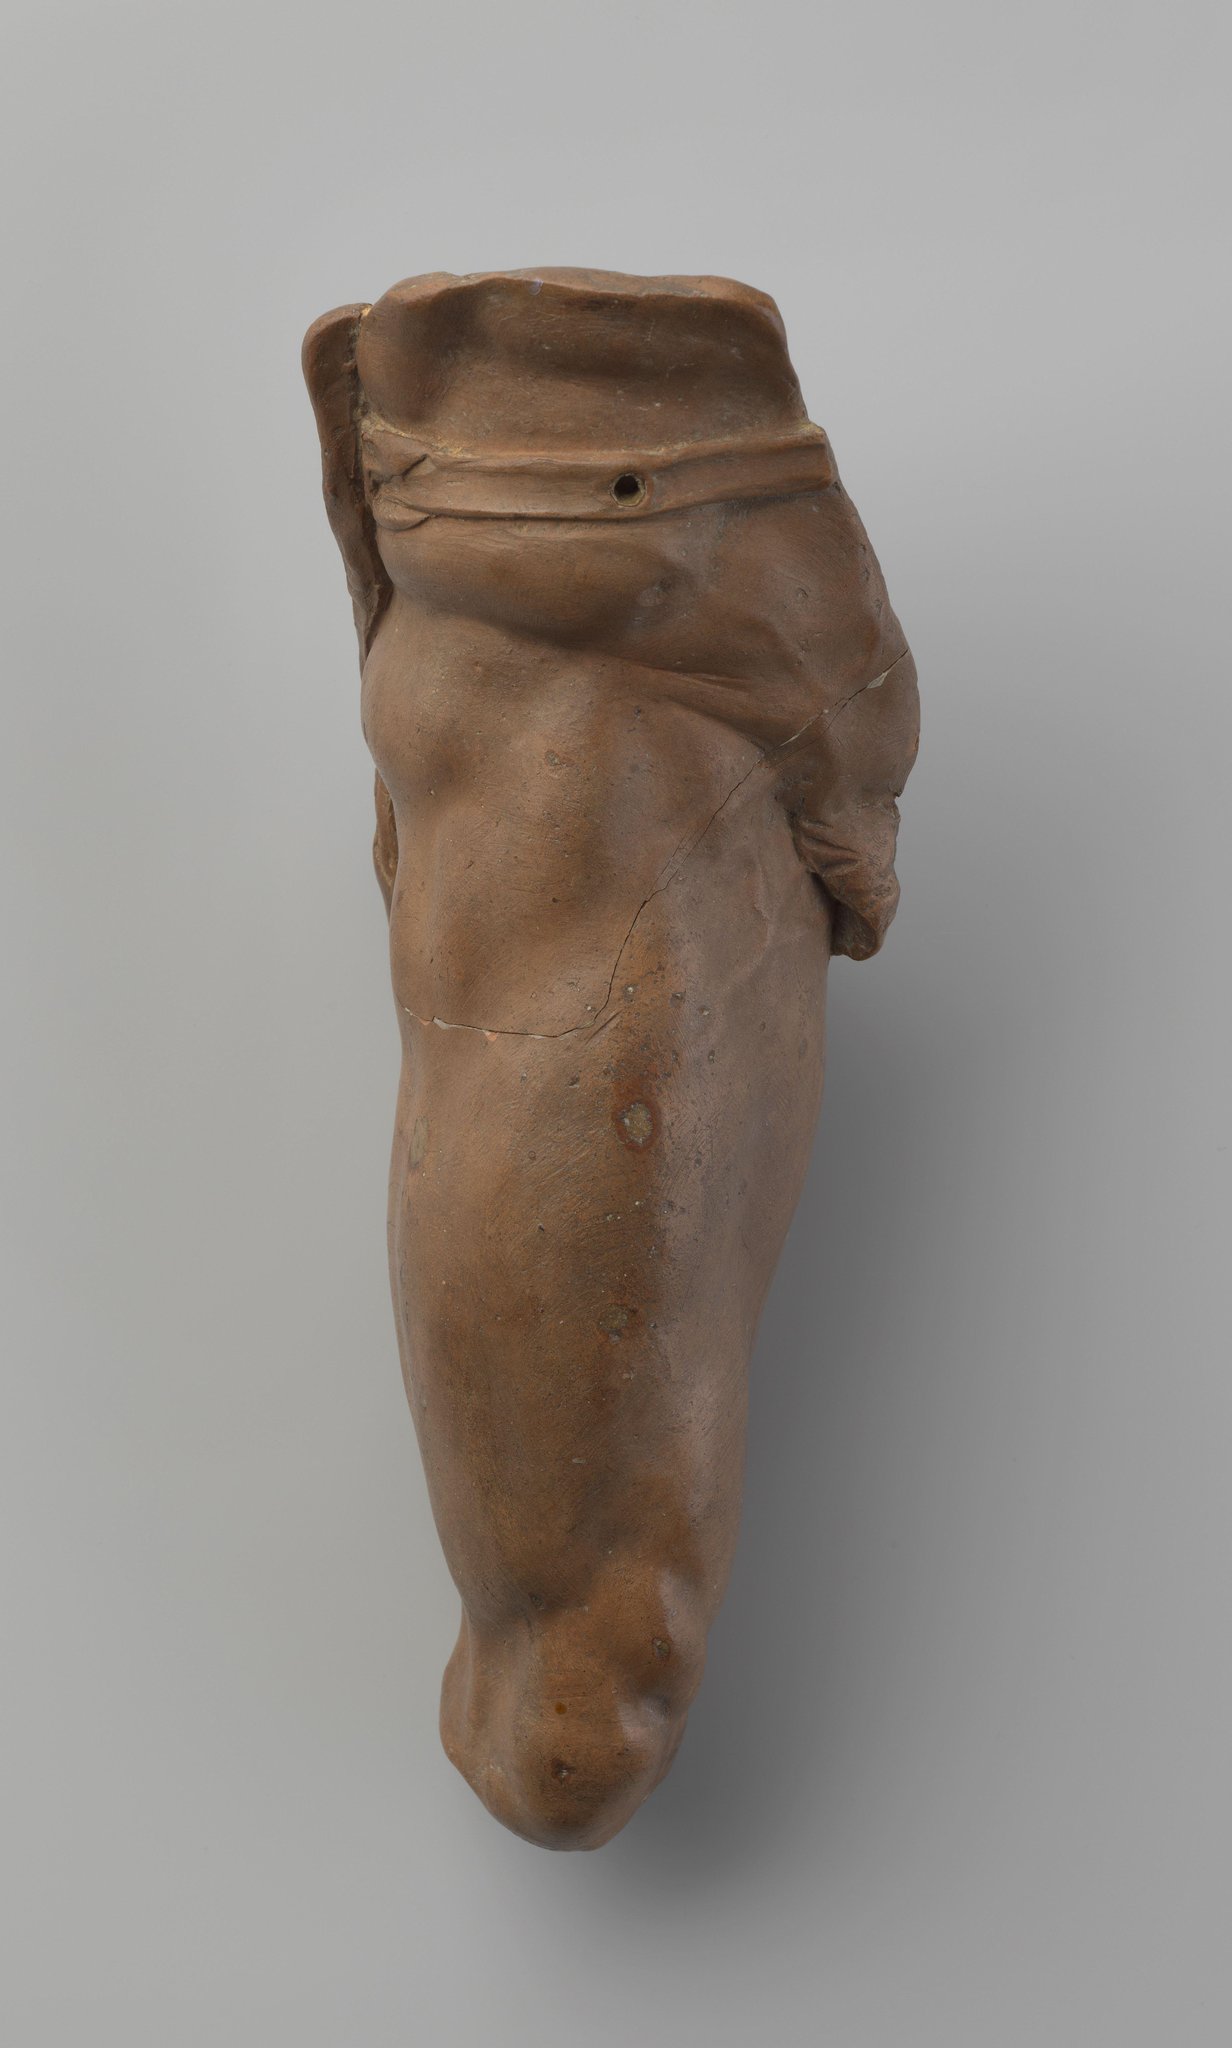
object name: model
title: Study Models of Parts of the Body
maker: johan gregor van der schardt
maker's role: sculptor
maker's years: 1530-1581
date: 1560-1570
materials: terracotta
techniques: firing, molding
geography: italy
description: This group of small models of parts of the body is carefully copied after famous sculptures, in particular by Michelangelo, in Florence and Rome. They came from the workshop of the Nijmegen sculptor Johan Gregor van der Schardt, who had a successful career in Italy, Nuremberg, and Copenhagen. They are extremely rare examples of the, in part autograph, study material of a 16th-century sculptor.